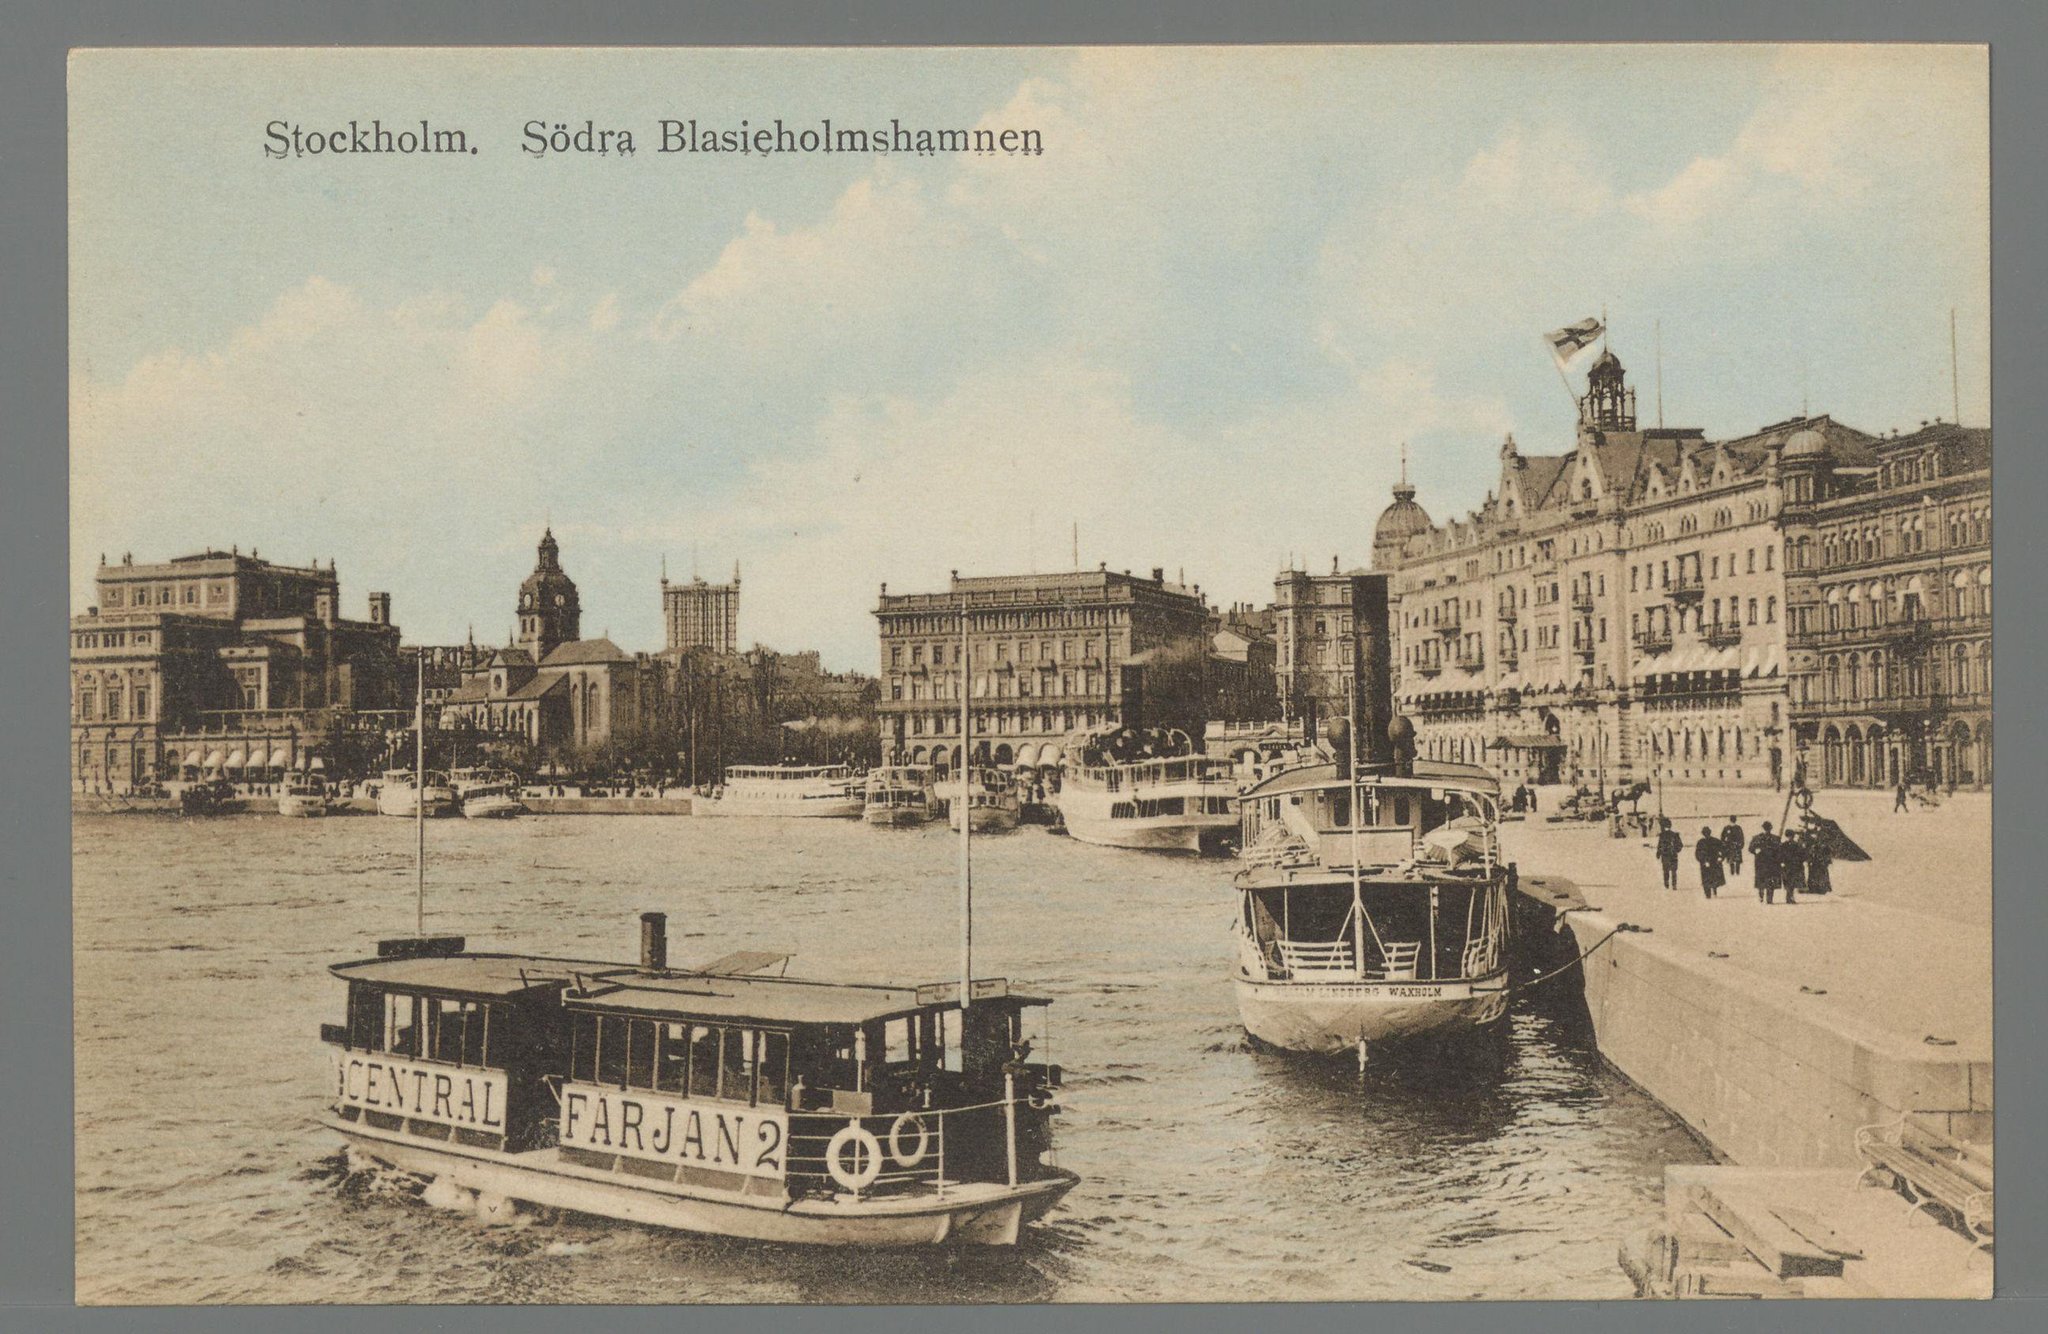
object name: ansichtkaart, prentbriefkaart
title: Stockholm. Södra Blasieholmshamnen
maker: Anonymous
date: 1905-1930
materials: cardboard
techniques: photograph, lithograph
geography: stockholm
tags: avenue, boulevard, promenade, esplanade